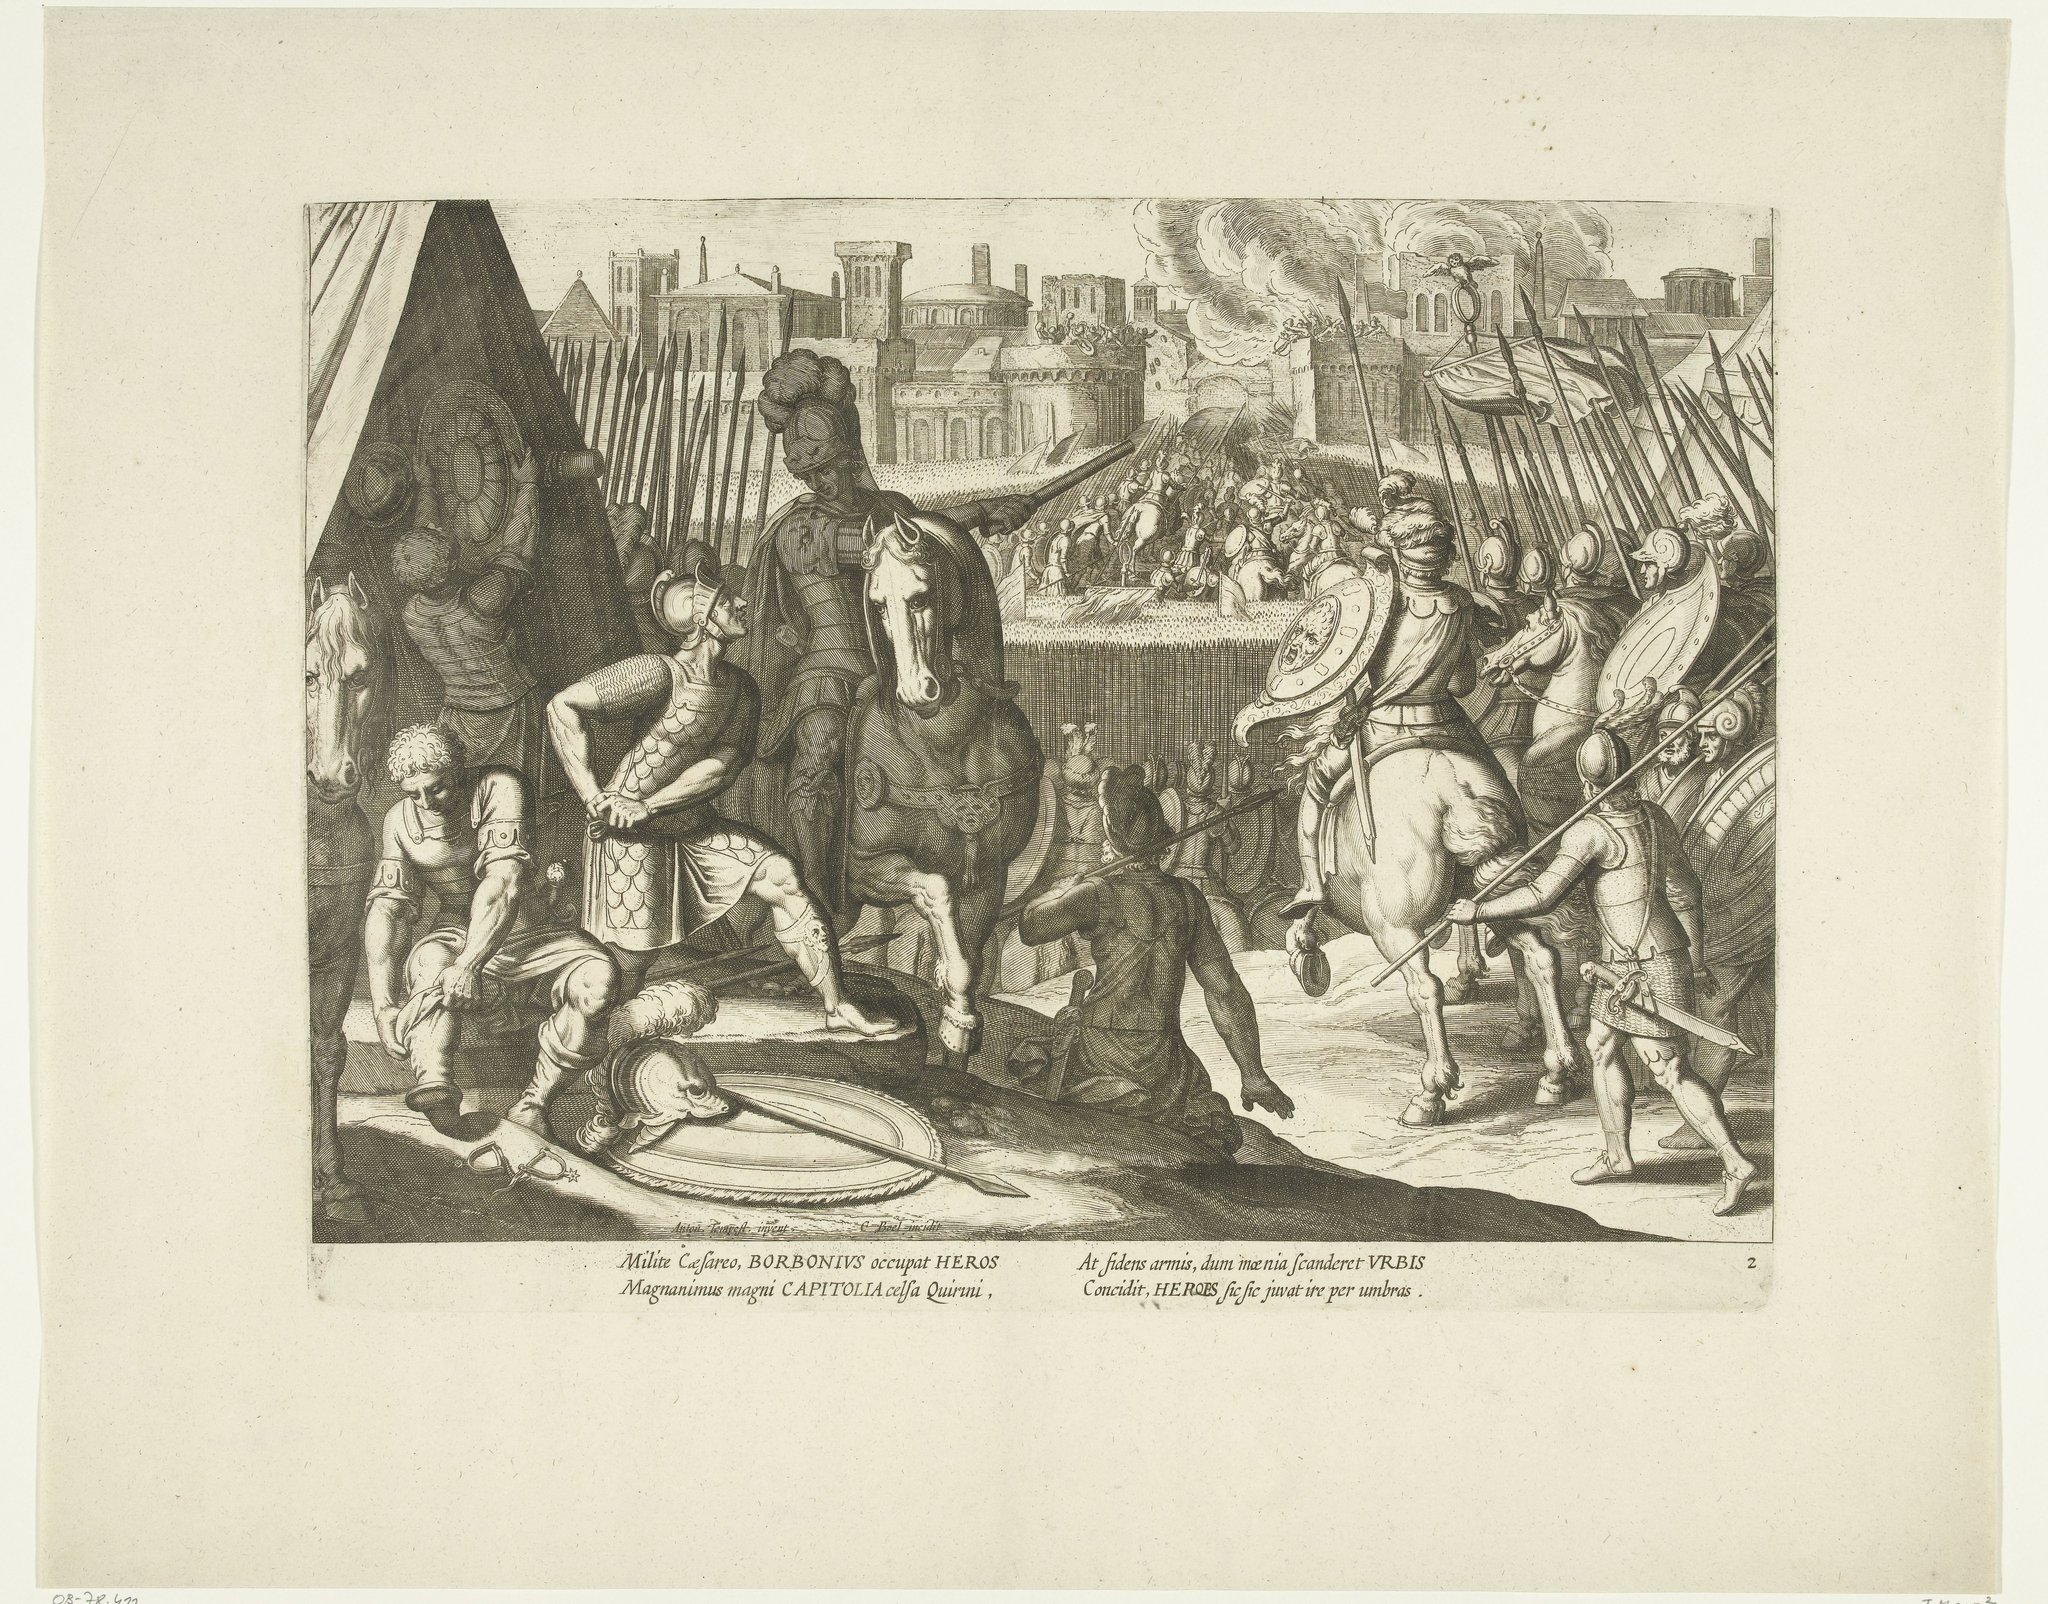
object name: history print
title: Verovering van Rome, 1527, nr. 2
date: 1614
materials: paper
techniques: engraving, etching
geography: leiden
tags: ghent, charles v (holy roman emperor and king of spain), battle, fighting in general, rome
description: Legers onder leiding van Karel V veroveren Rome, 1527. Op de voorgrond maken soldaten zich klaar voor de strijd, op de achtergrond bestormen de legers een poort van de stad. Met onderschrift van vier regels in het Latijn.